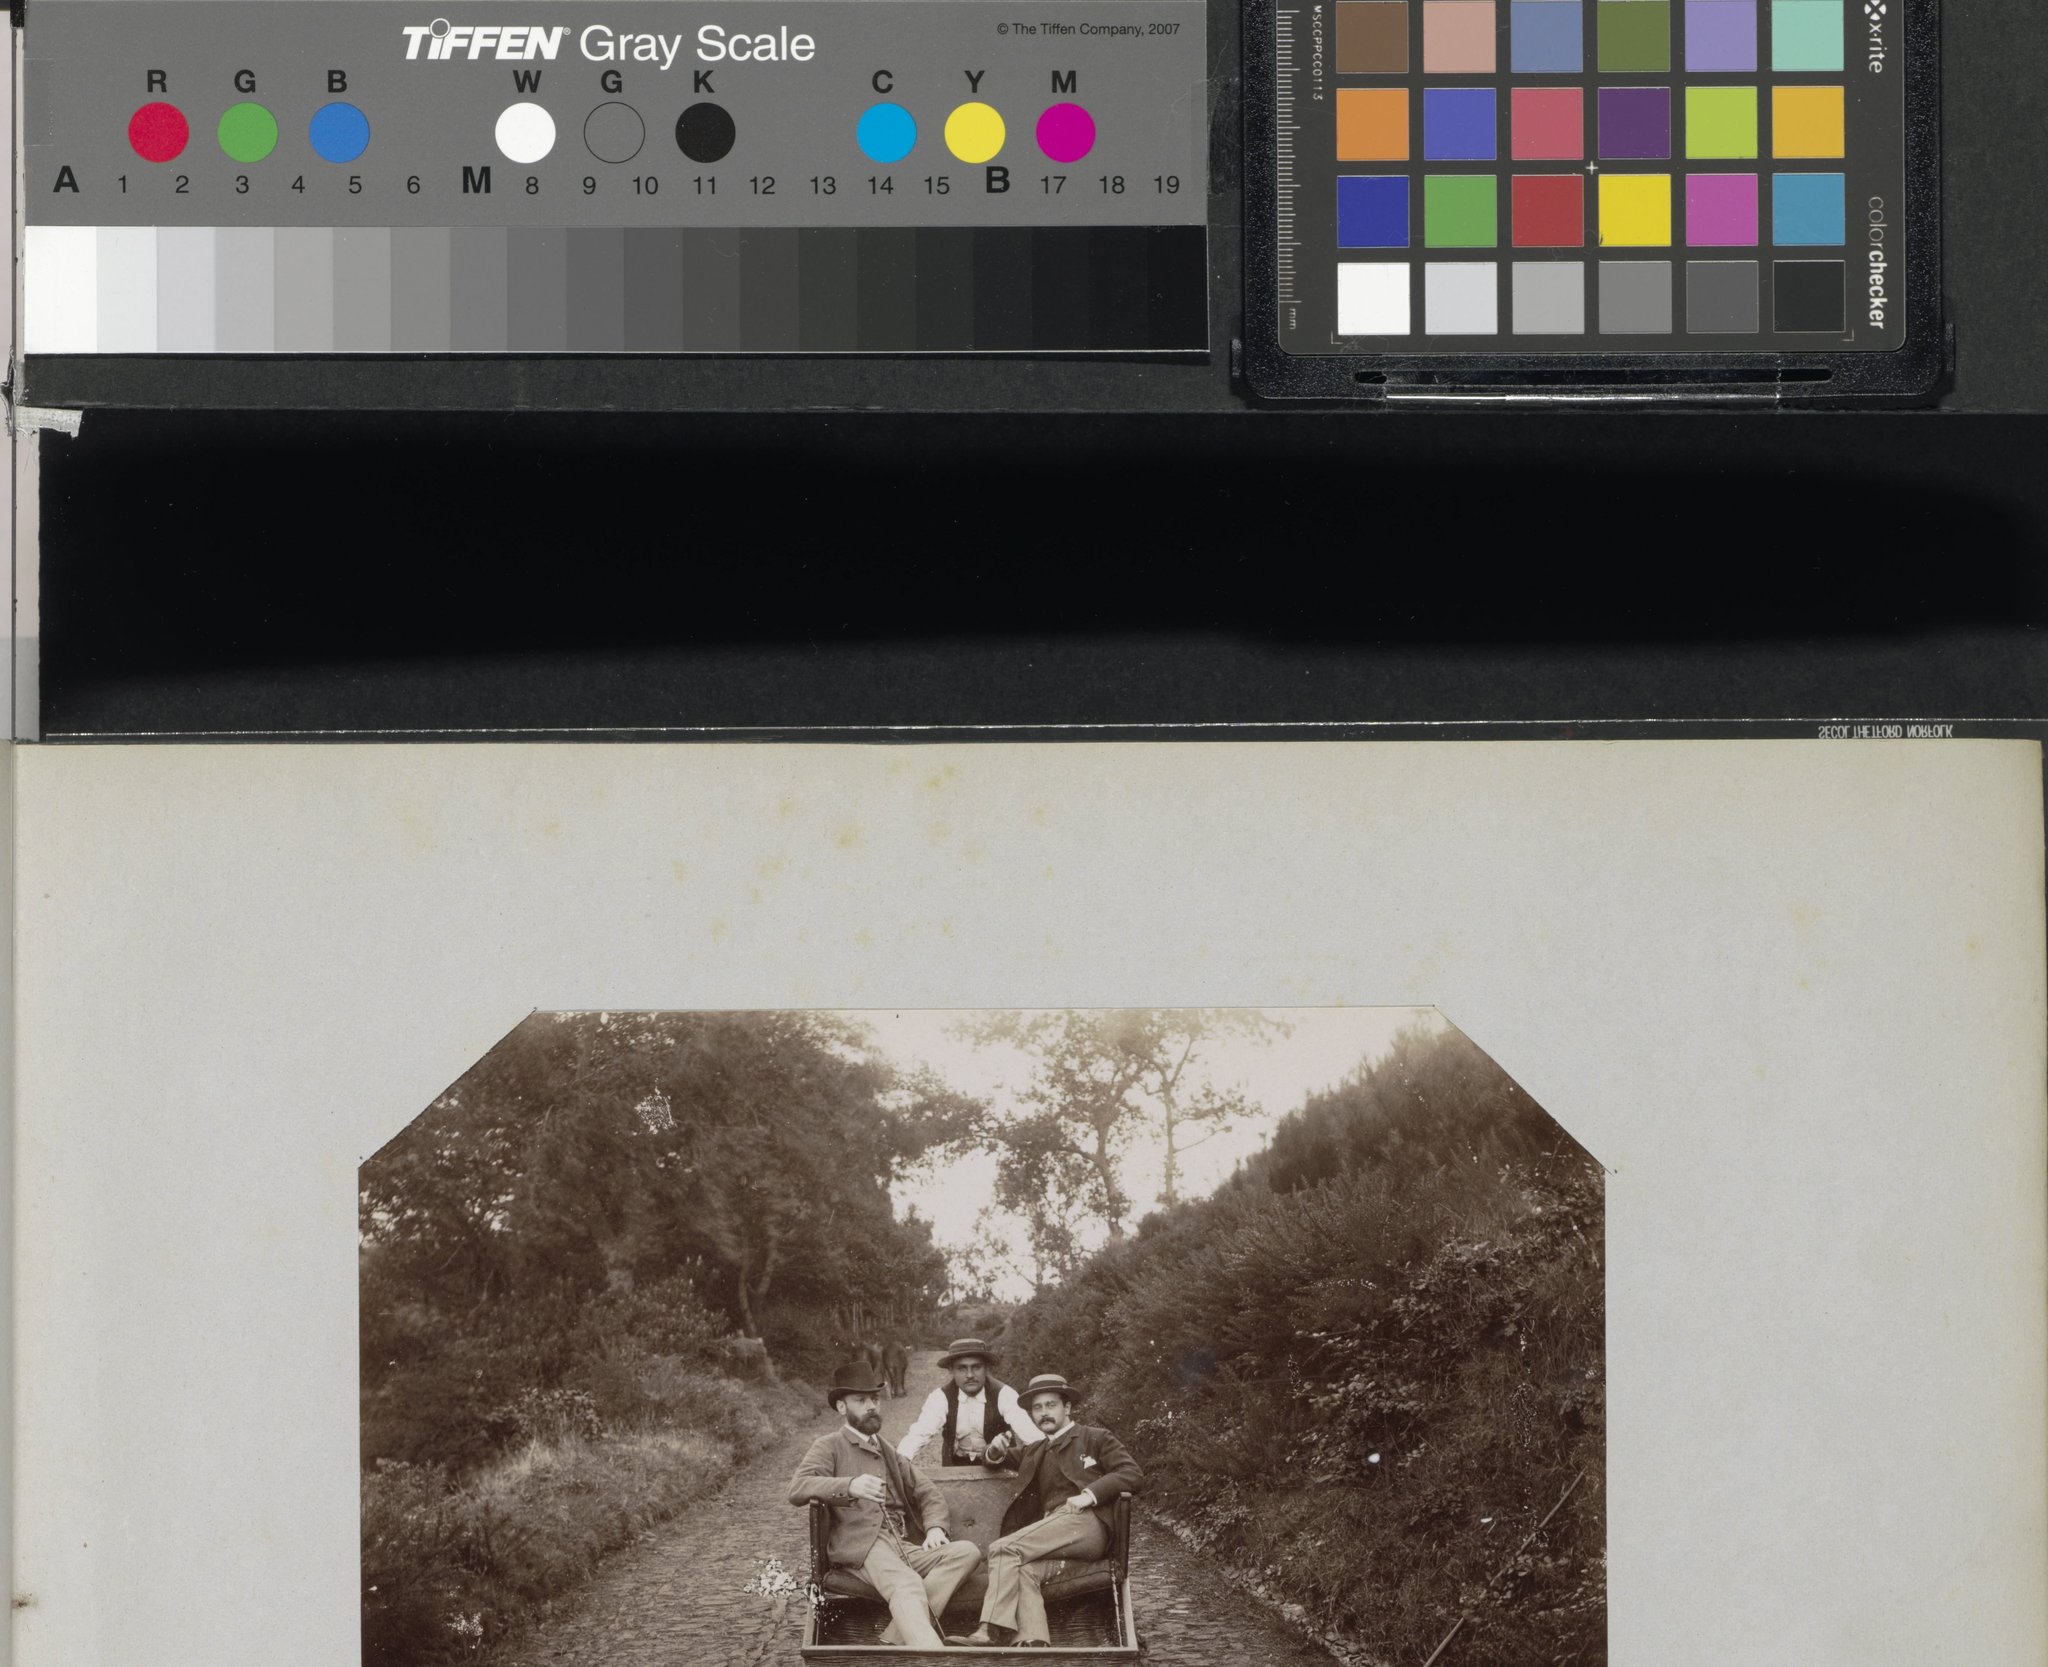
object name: photograph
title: Twee mannen in toeslede op een helling te Madeira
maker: Anonymous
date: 1896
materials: photographic support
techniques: albumen print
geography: madeira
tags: animal-drawn sledge (dutch: 'toeslede')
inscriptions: annotation: ‘Madeira. "The Slide" 15 Januari 1896’